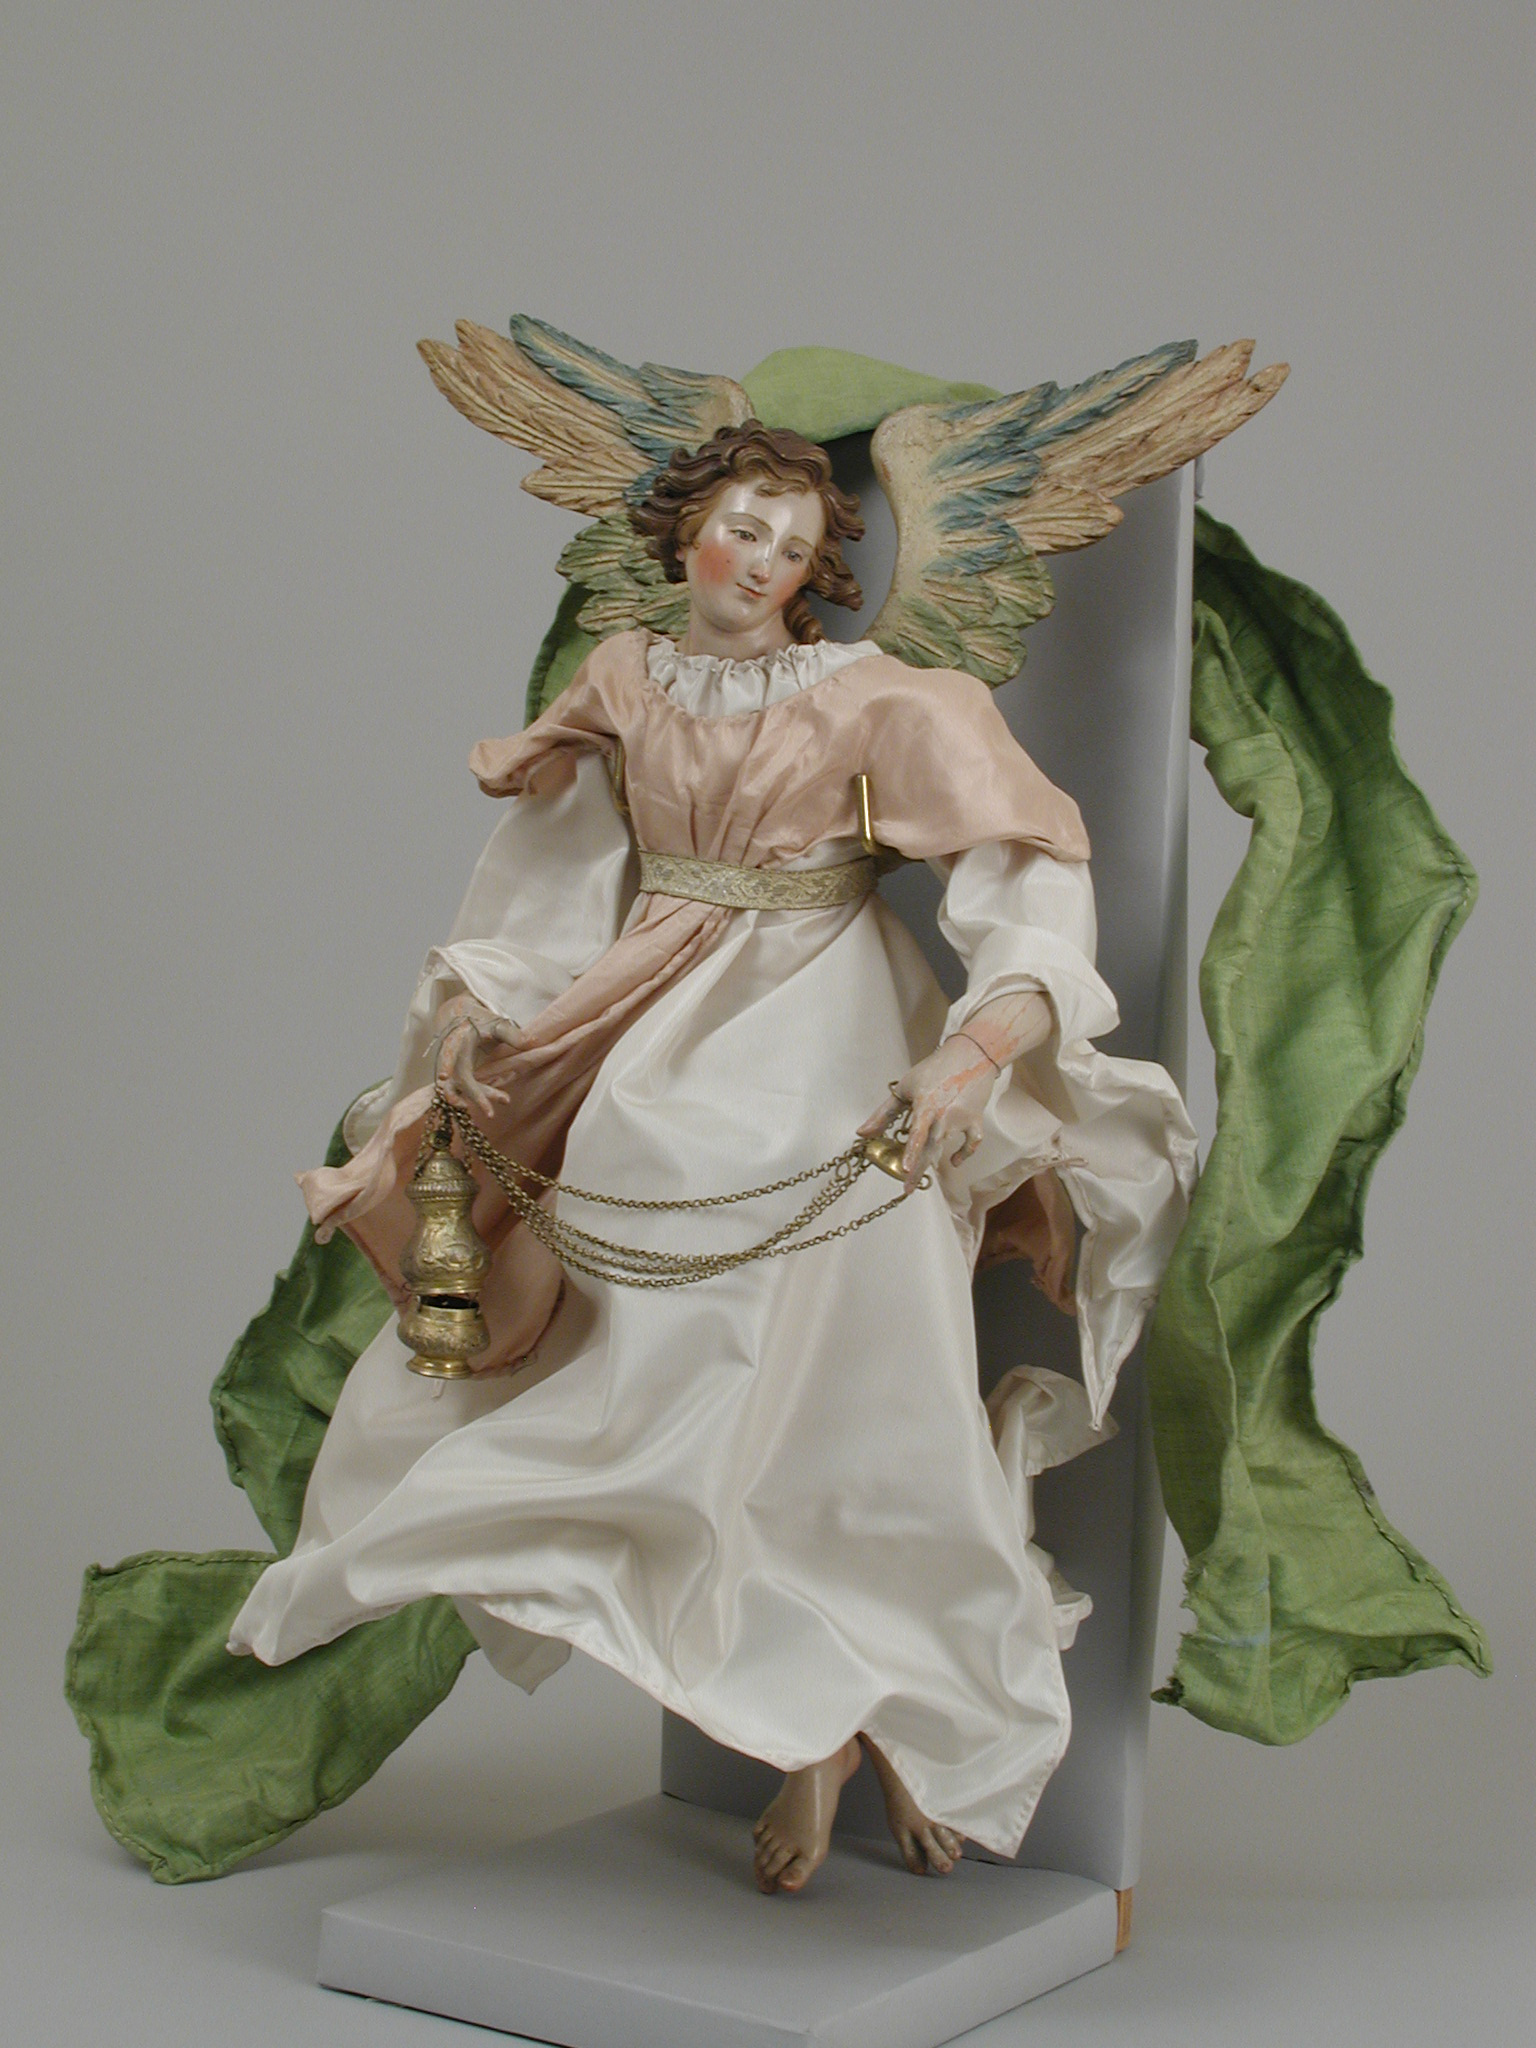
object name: crèche figure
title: Angel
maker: giuseppe gori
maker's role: maker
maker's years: 1770-1810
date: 1751-1800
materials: terracotta, fiber, metal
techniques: polychrome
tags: angels,censers